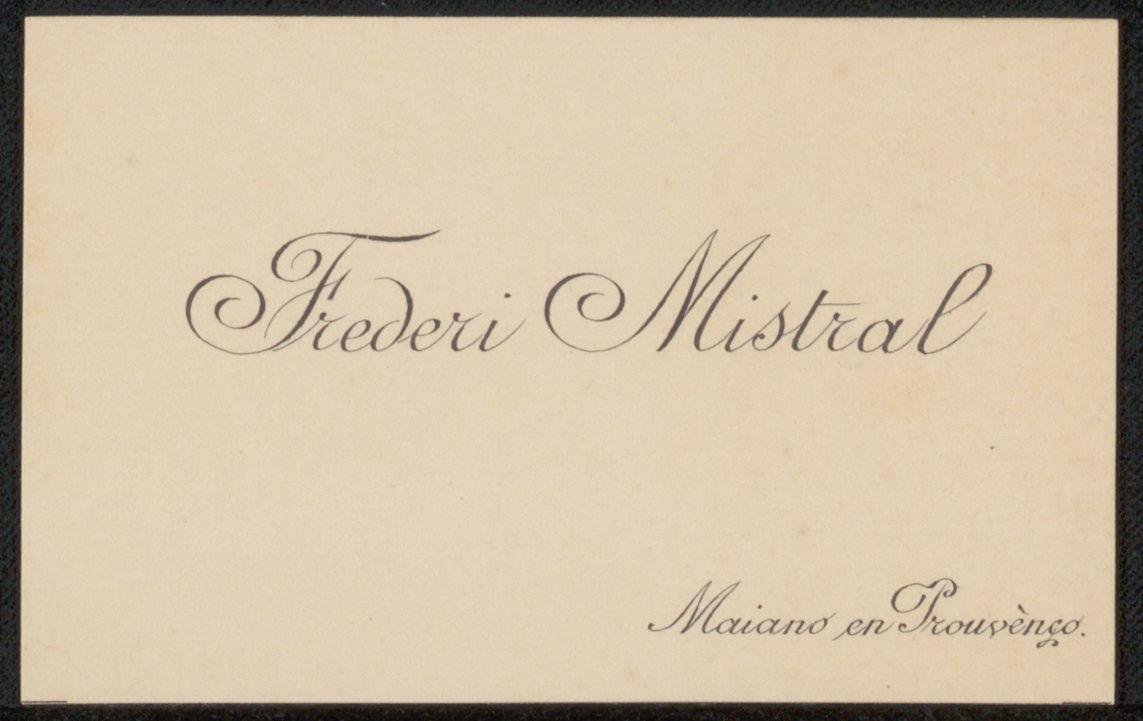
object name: visiting card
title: Visitekaartje aan Philip Zilcken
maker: frédéric mistral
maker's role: schrijver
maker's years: 1830-1914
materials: cardboard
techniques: printing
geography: maillane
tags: painter, draughtsman, philip zilcken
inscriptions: collector's mark: ‘RPK’